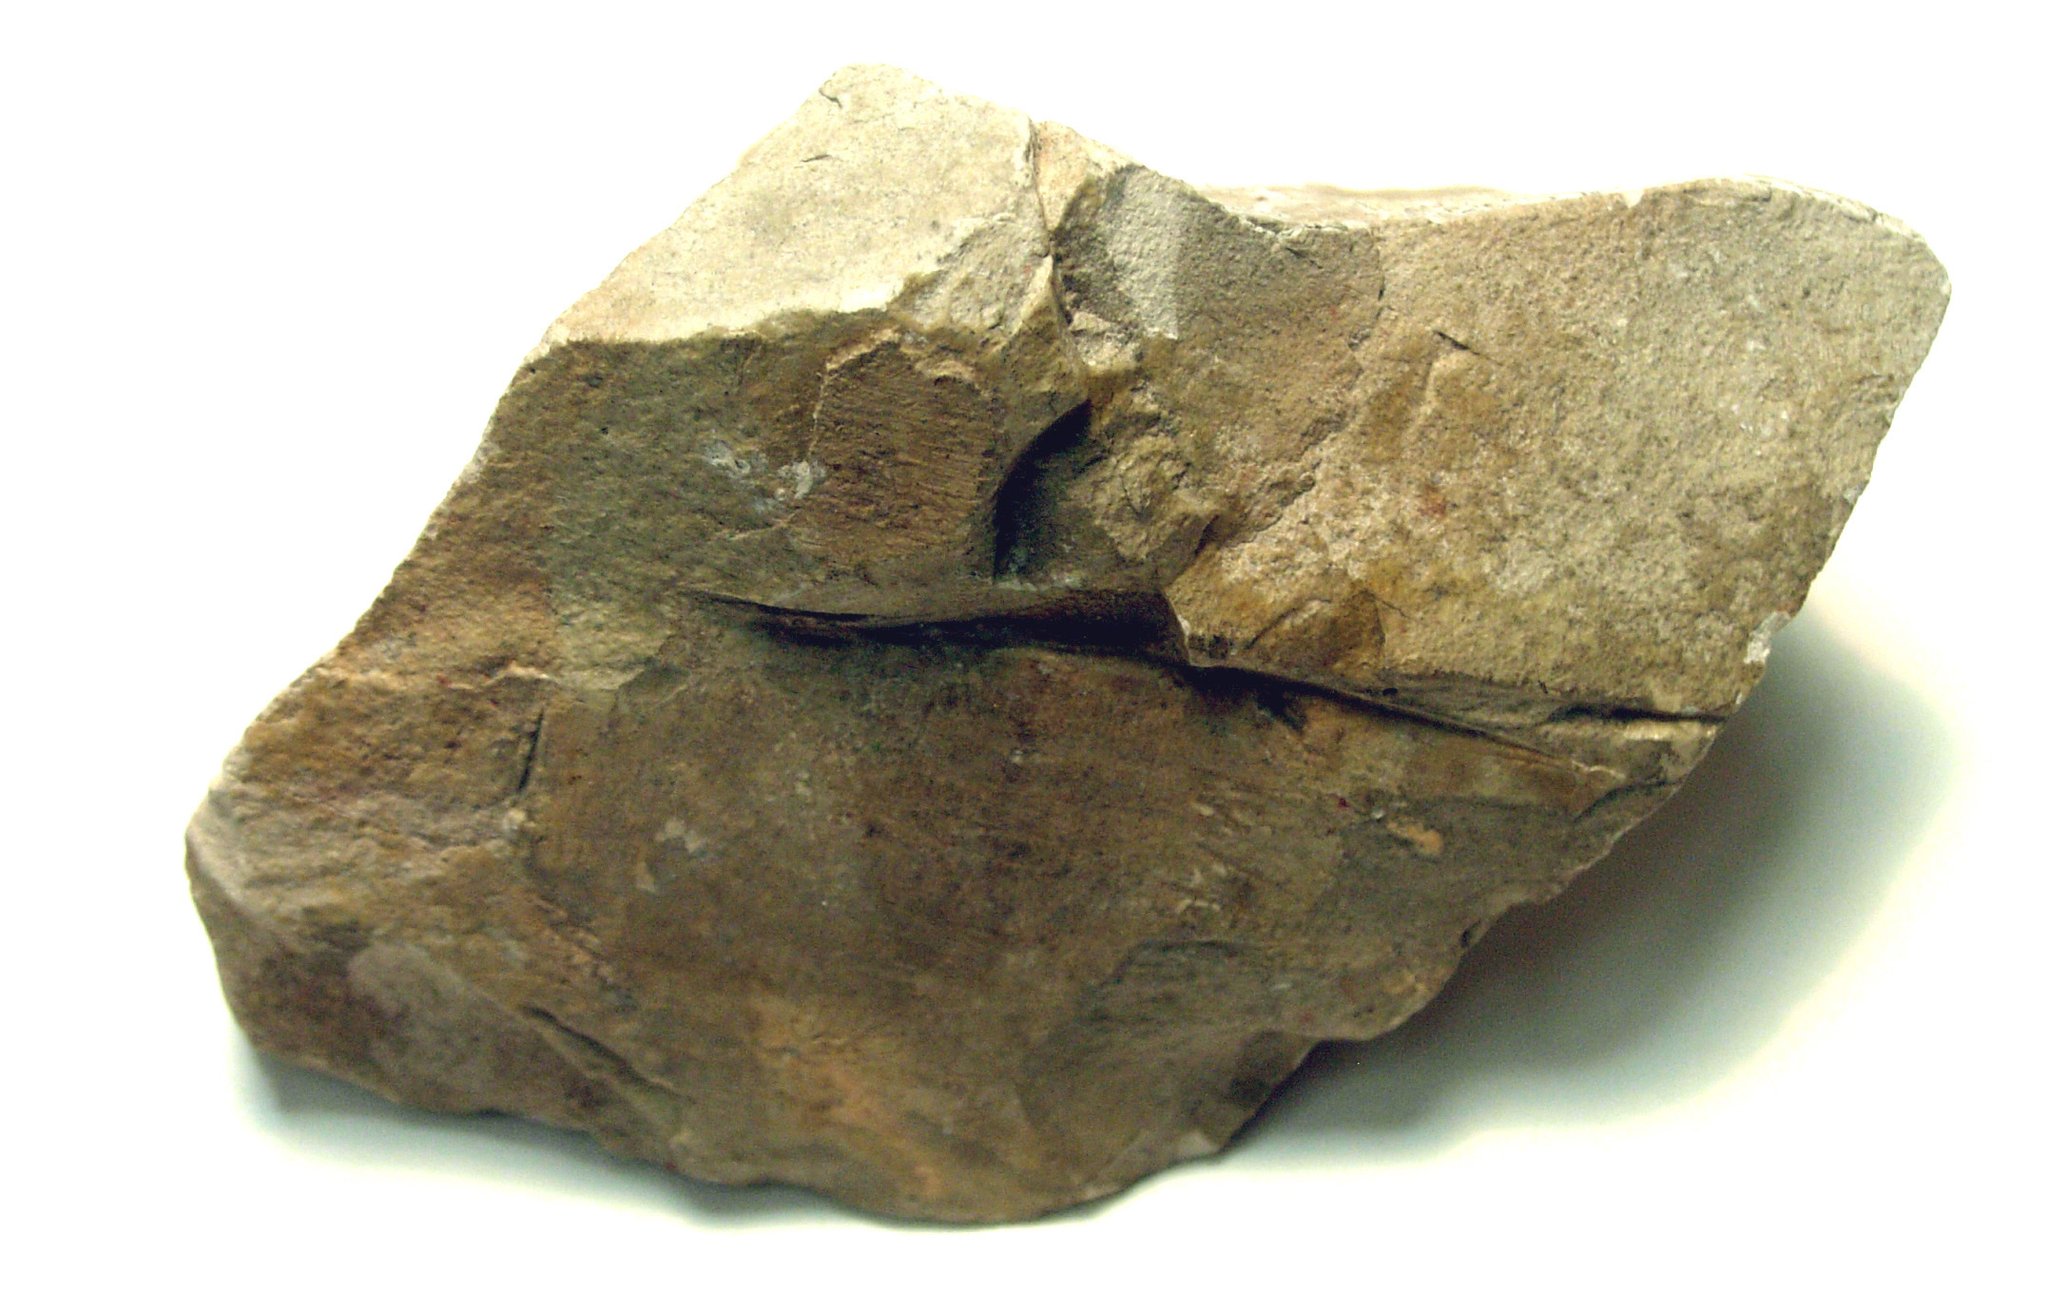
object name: relief, tomb of nespekashuty, wall casing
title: Wall casing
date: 664-610 BCE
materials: limestone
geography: egypt